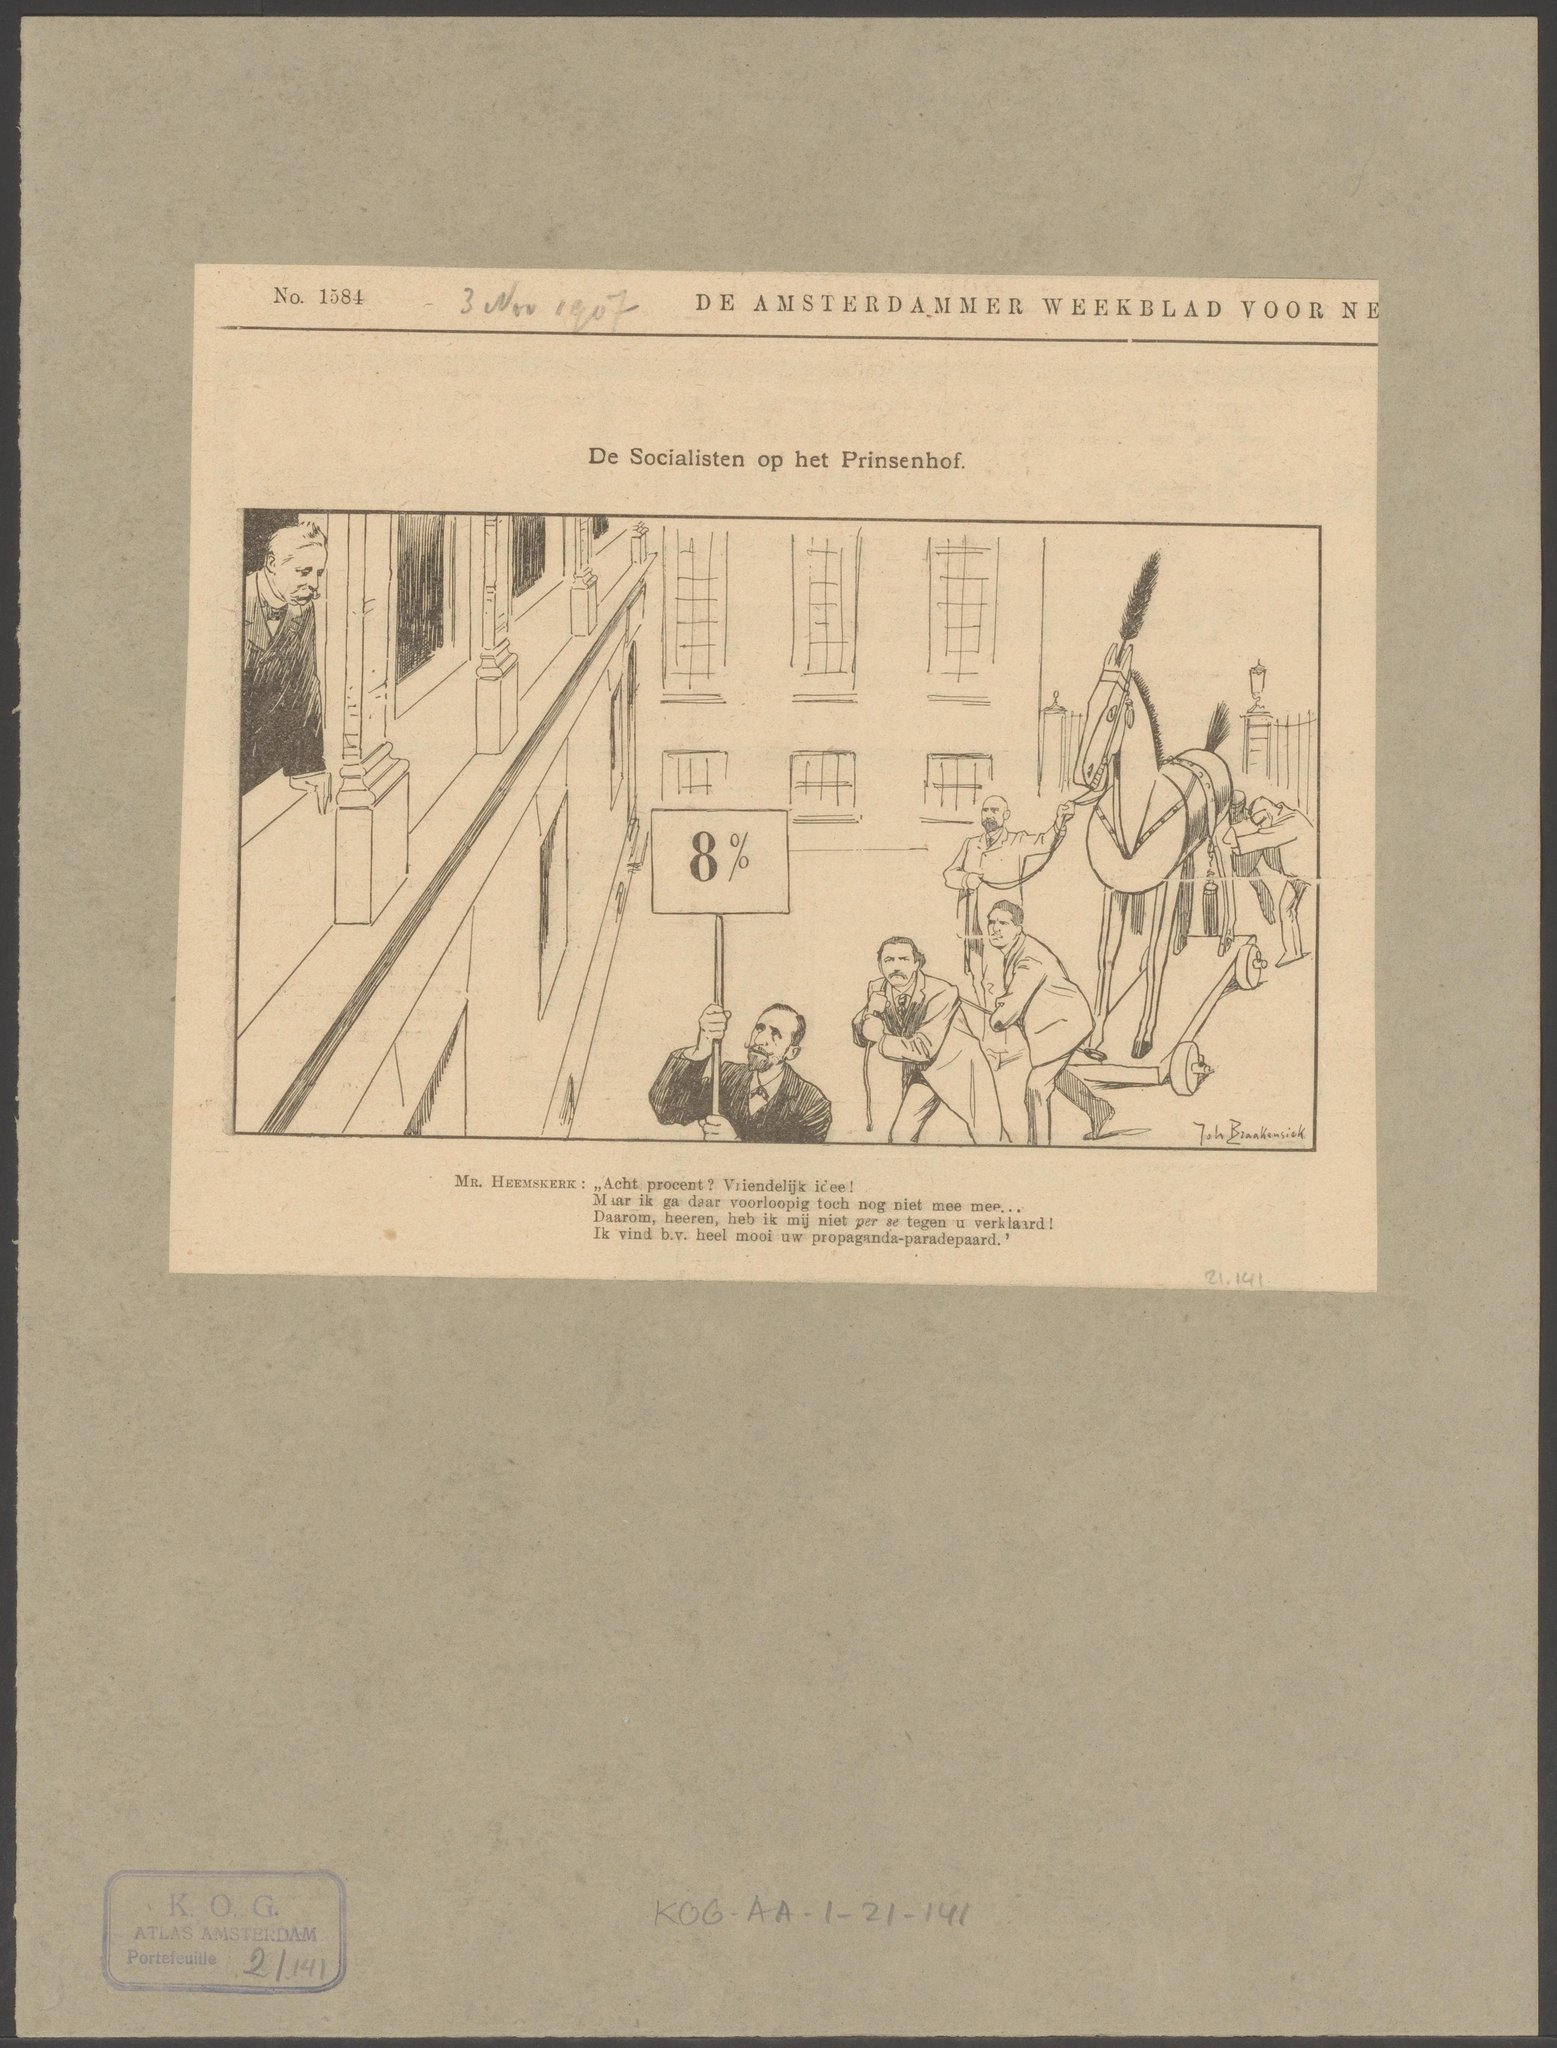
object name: cartoon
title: Theodorus Heemskerk kijkt uit zijn raam hoe mannen een houten paard het Prinsenhof op rijden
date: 1907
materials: paper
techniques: letterpress printing, line block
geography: amsterdam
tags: amsterdam, the trojan horse, political demonstration, politician, e.g. party leader, horse, political caricatures and satires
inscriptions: collector's mark: Lugt 1641b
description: Prent uit: De Amsterdammer (1907), 3 november 1907, p. 11.